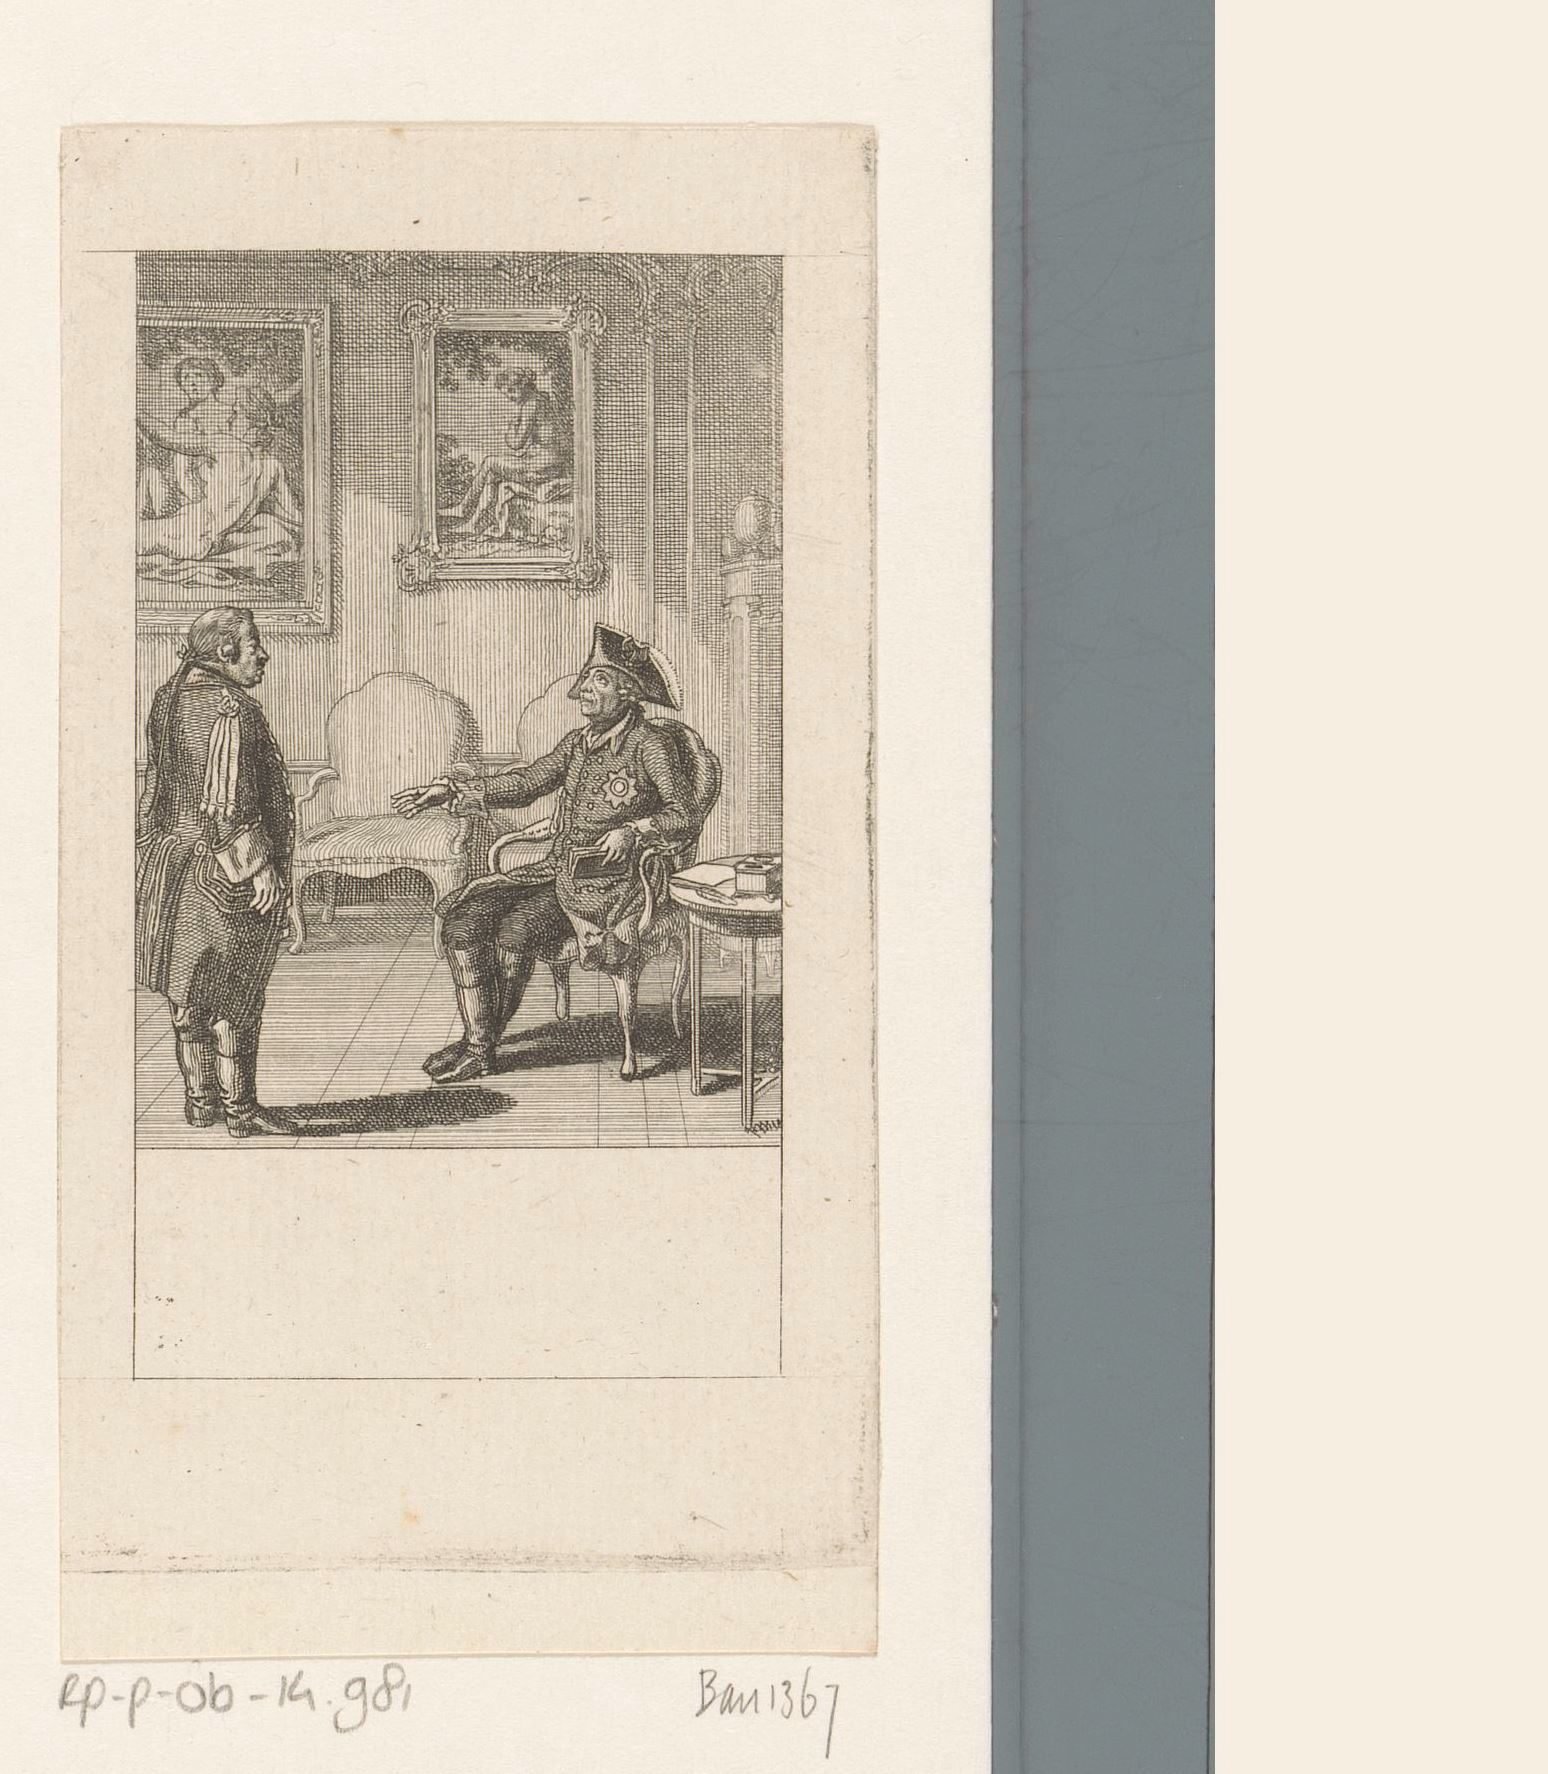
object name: print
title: Frederik II bespreekt de kosten van het feest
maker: daniel nikolaus chodowiecki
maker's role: draughtsman, print maker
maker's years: 1726-1801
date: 1788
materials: paper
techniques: etching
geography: berlin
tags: frederick ii (king of prussia), ruler, sovereign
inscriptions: collector's mark: Lugt 2228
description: Latere staat gebruikt voor: Gothaischer Hof Kalender zum Nutzen und Vergnügen eingerichtet auf das Jahr 1789. Gotha: C. W. Ettinger, [1788].